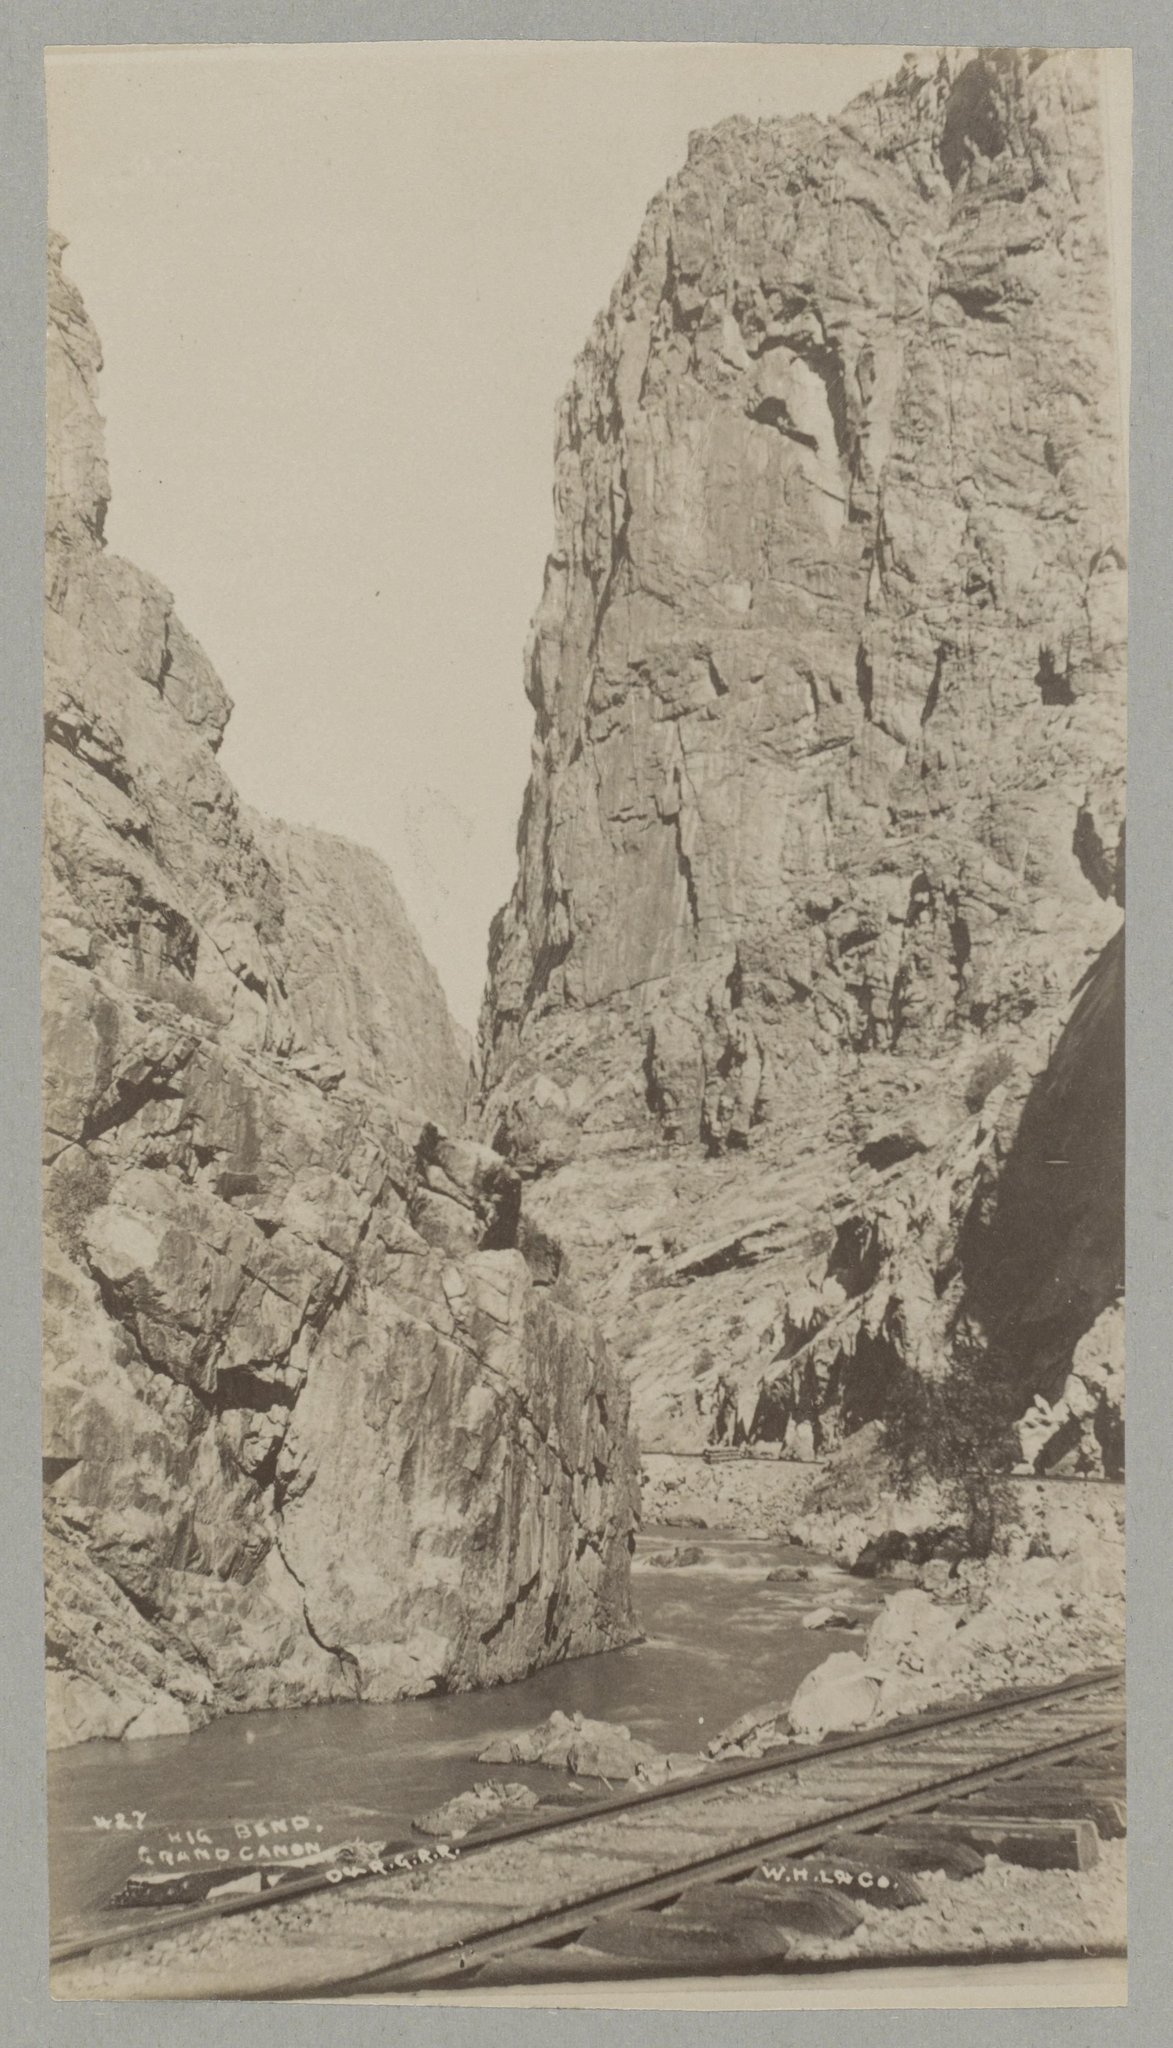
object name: photograph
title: Big Bend. Grand Canyon D.&R.G.R.R.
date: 1880-1900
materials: cardboard, paper, photographic support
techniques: albumen print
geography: colorado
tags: ravine, chasm, abyss, canyon, railway, train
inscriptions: negative number: ‘427’